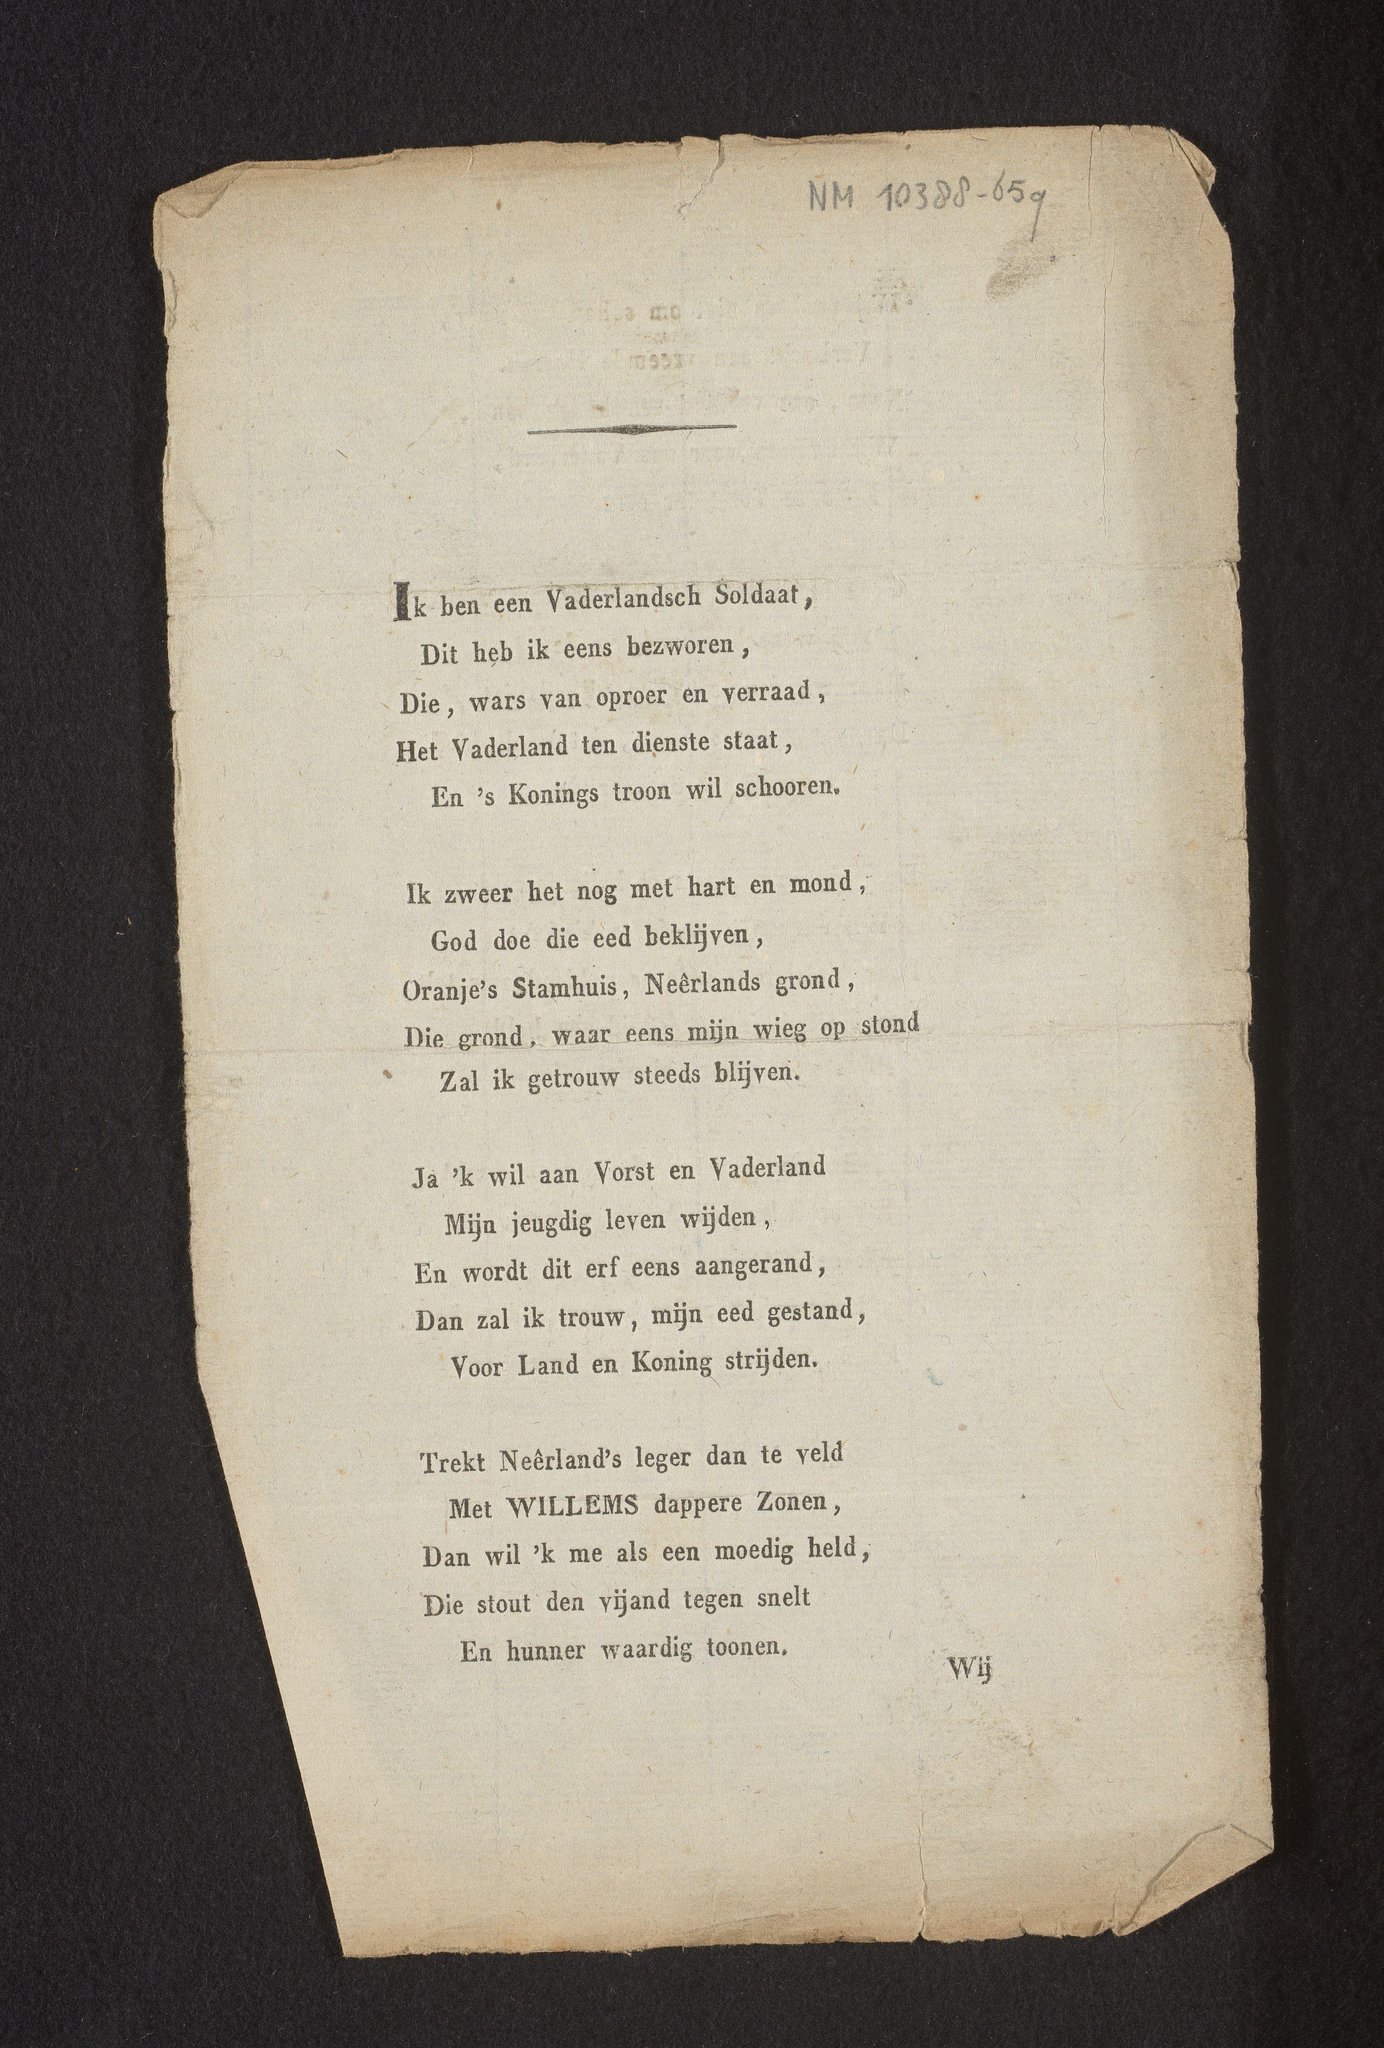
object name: poem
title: Ik ben een Vaderlandsch soldaat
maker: Anonymous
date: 1830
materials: paper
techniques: printing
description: Eén vel papier, aan 2 zijden bedrukt, gedicht van 8 strofen ("Ik ben een Vaderlandsch soldaat" .... "Komt, schaart u om zijn vanen!"). Hoort zeer waarschijnlijk ergens bij.